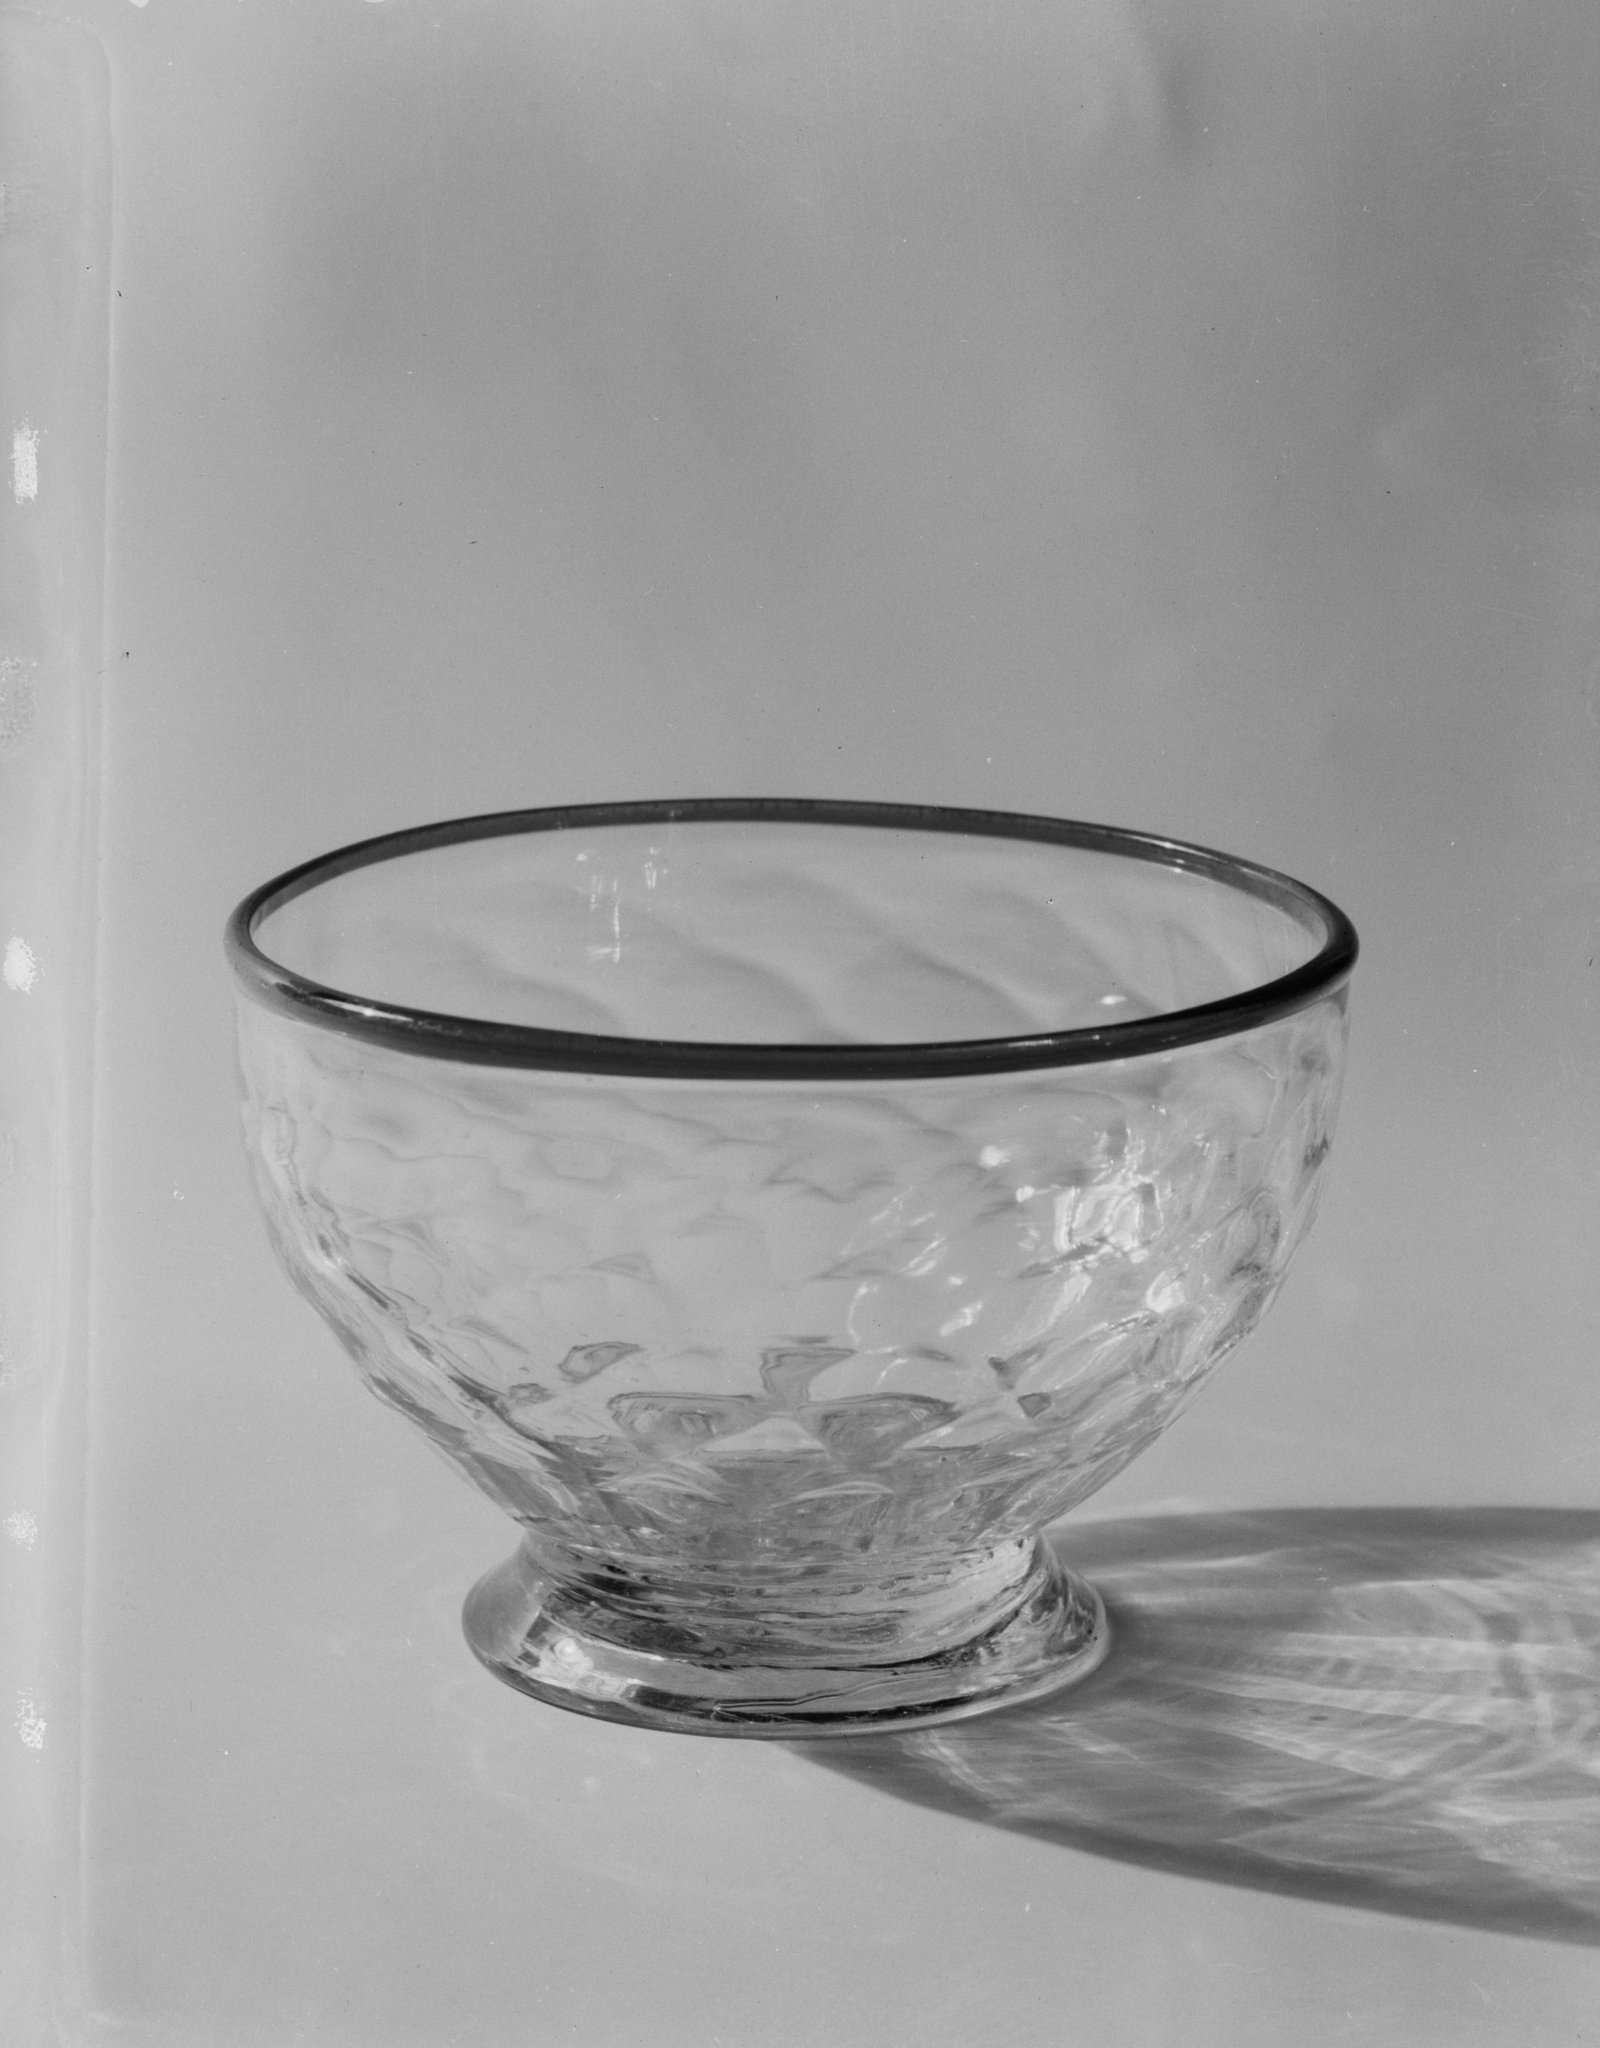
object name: bowl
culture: british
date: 1780-1820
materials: glass, lead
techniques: glassblowing, molding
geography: england